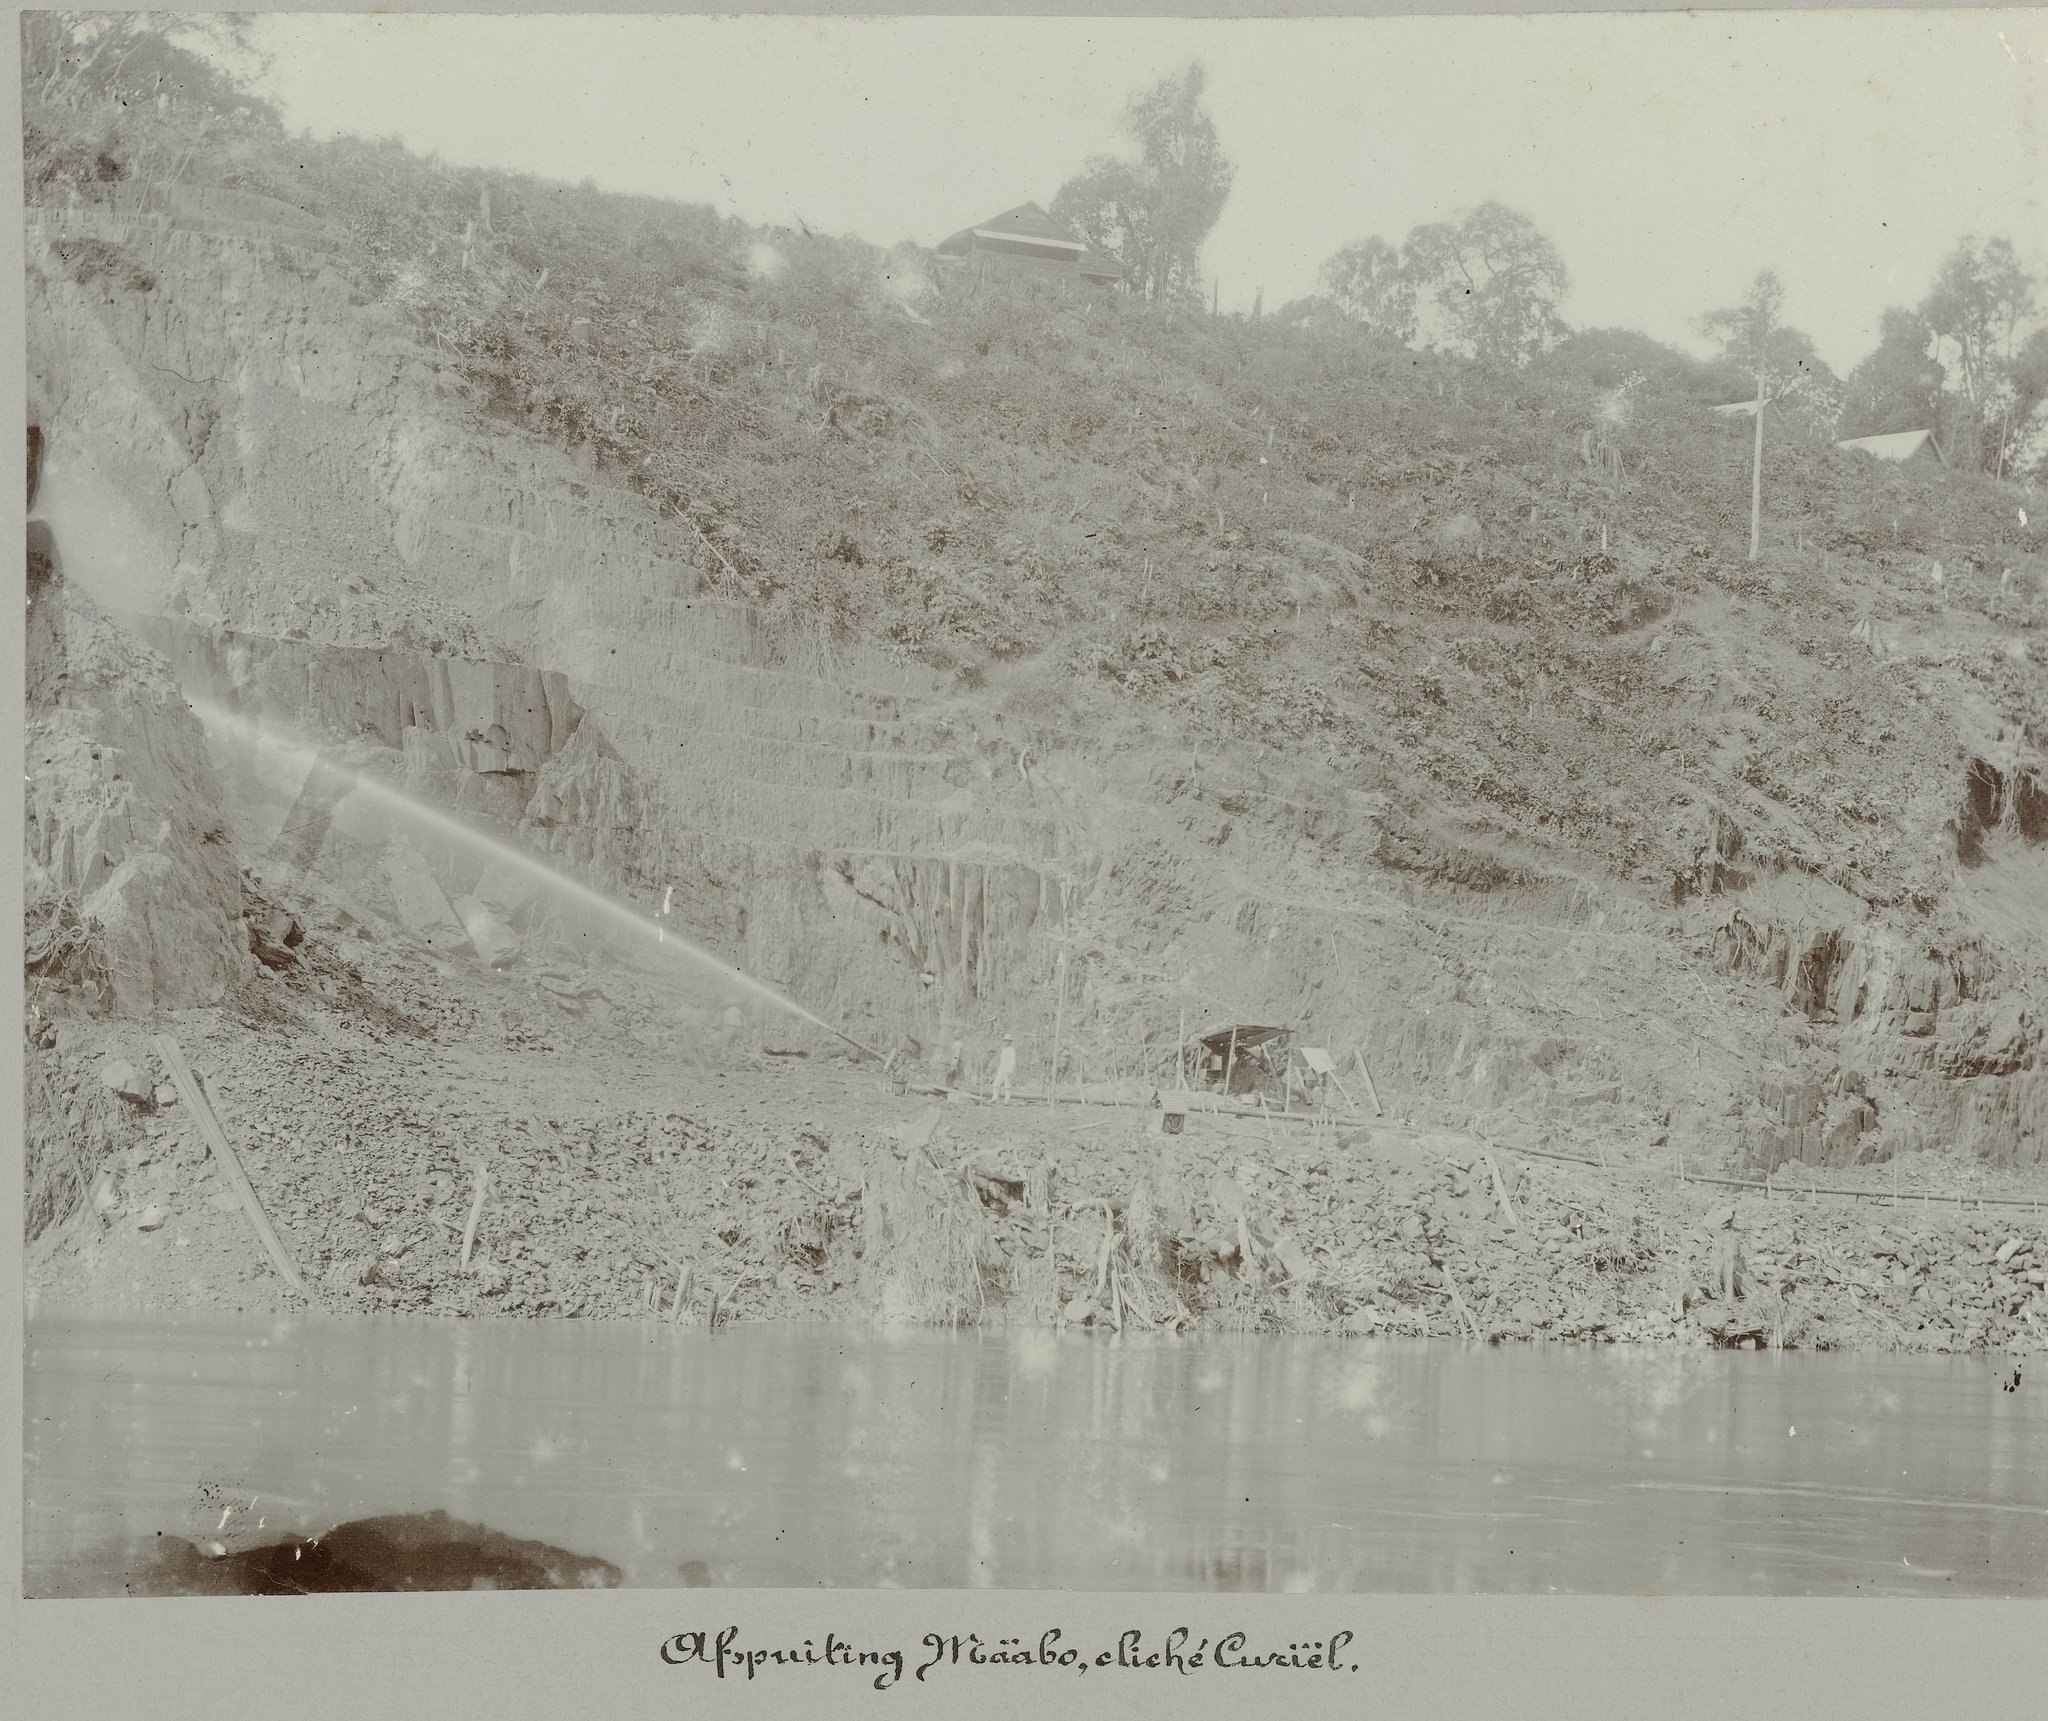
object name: photograph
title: Afspuiting Mäabo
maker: augusta curiel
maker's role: fotograaf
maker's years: 1873-1937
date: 1900-1906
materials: photographic support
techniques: collodion silver print, gelatin silver print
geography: suriname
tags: suriname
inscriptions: inscription: ‘Afspuiting Mäabo, cliché Curiël.’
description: Gezicht op de Maäbo Heuvel met de afspuiting ten behoeve van de aanleg van de Lawaspoorweg (1903-1912). Onderdeel van het fotoalbum Souvenir de Voyage (deel 3), over het leven van de familie Dooyer in en rond de plantage Ma Retraite in Suriname in de jaren 1906-1913.